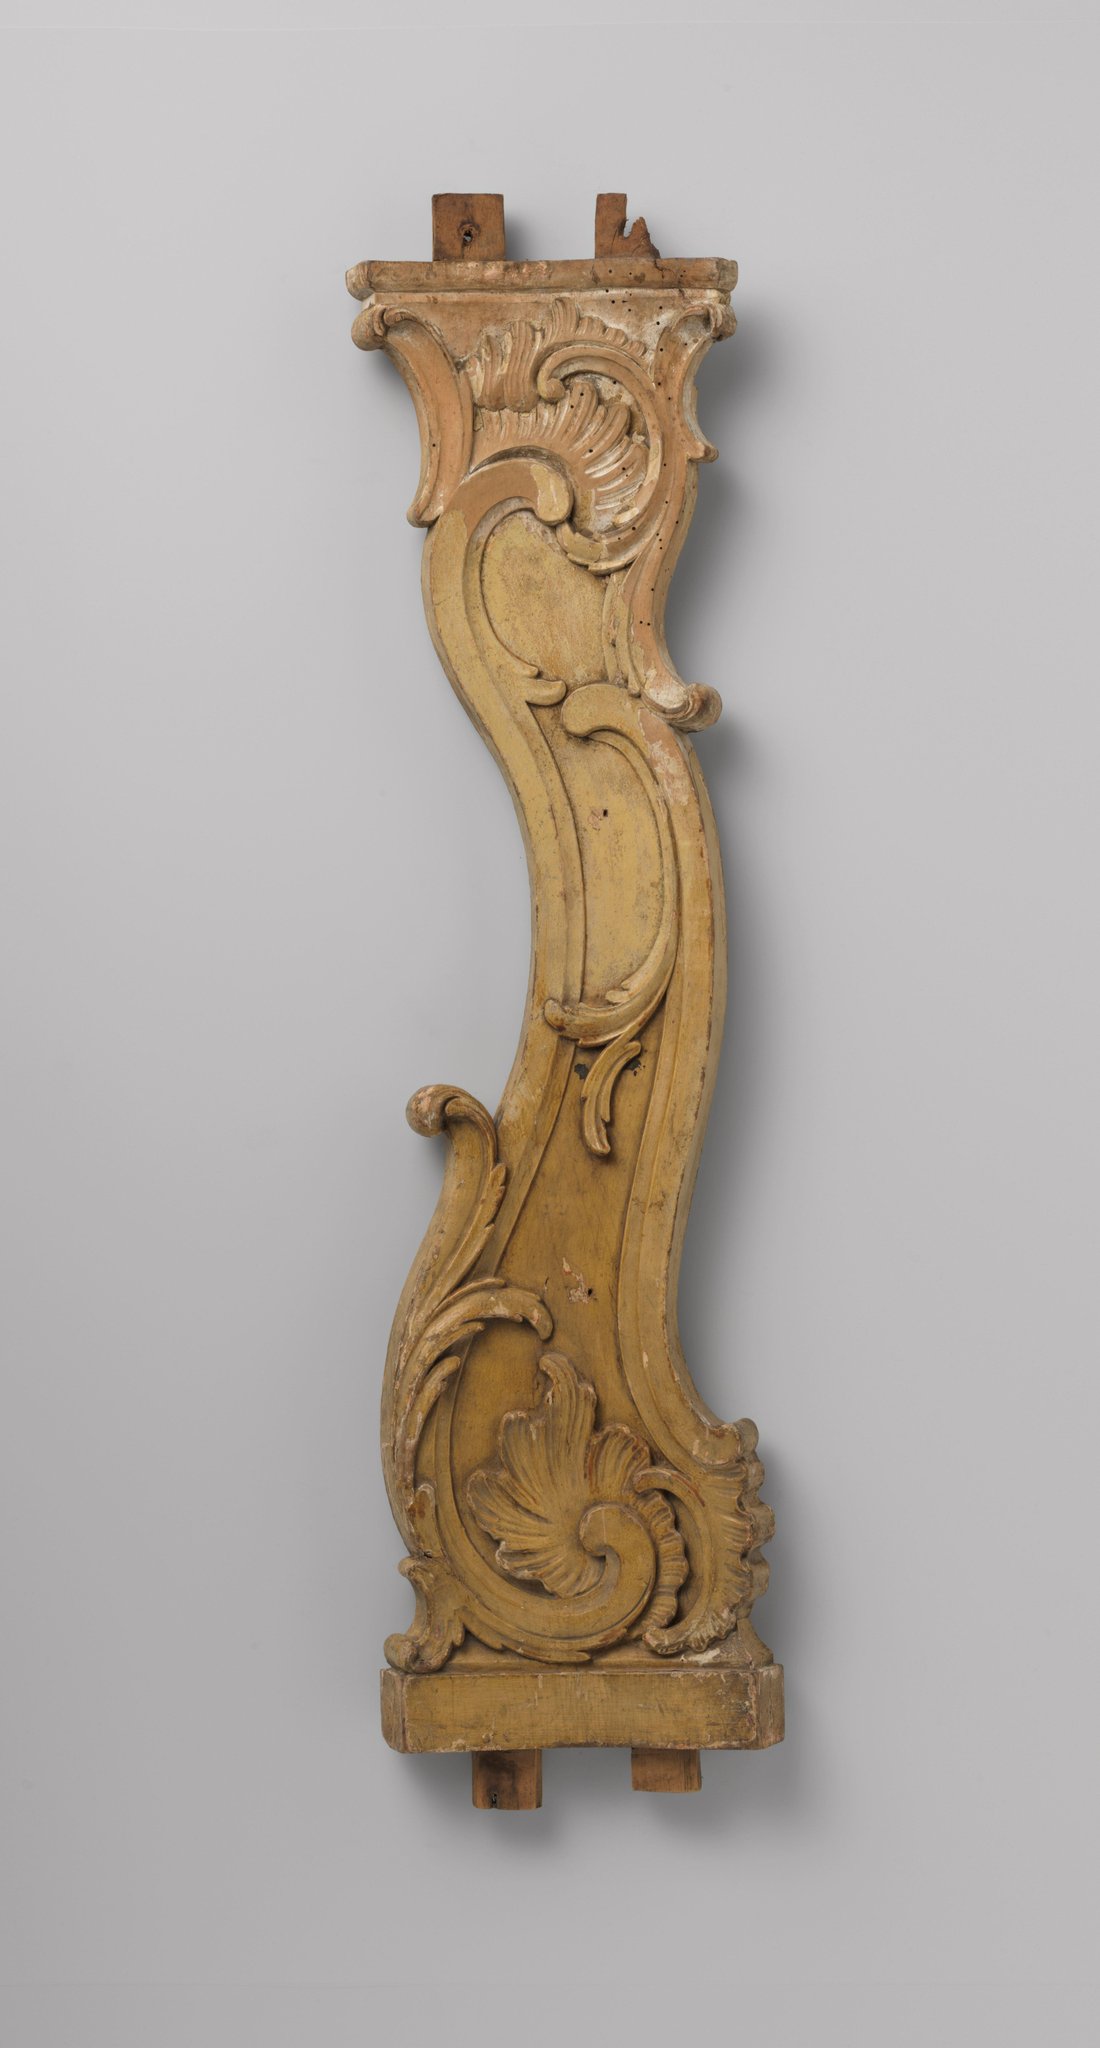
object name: railing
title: Baluster met gestoken C- en S-voluten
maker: Anonymous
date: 1740-1760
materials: wood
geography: northern netherlands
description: S-vormige baluster met gestoken C- en S-voluten met rocaille-schelpen.